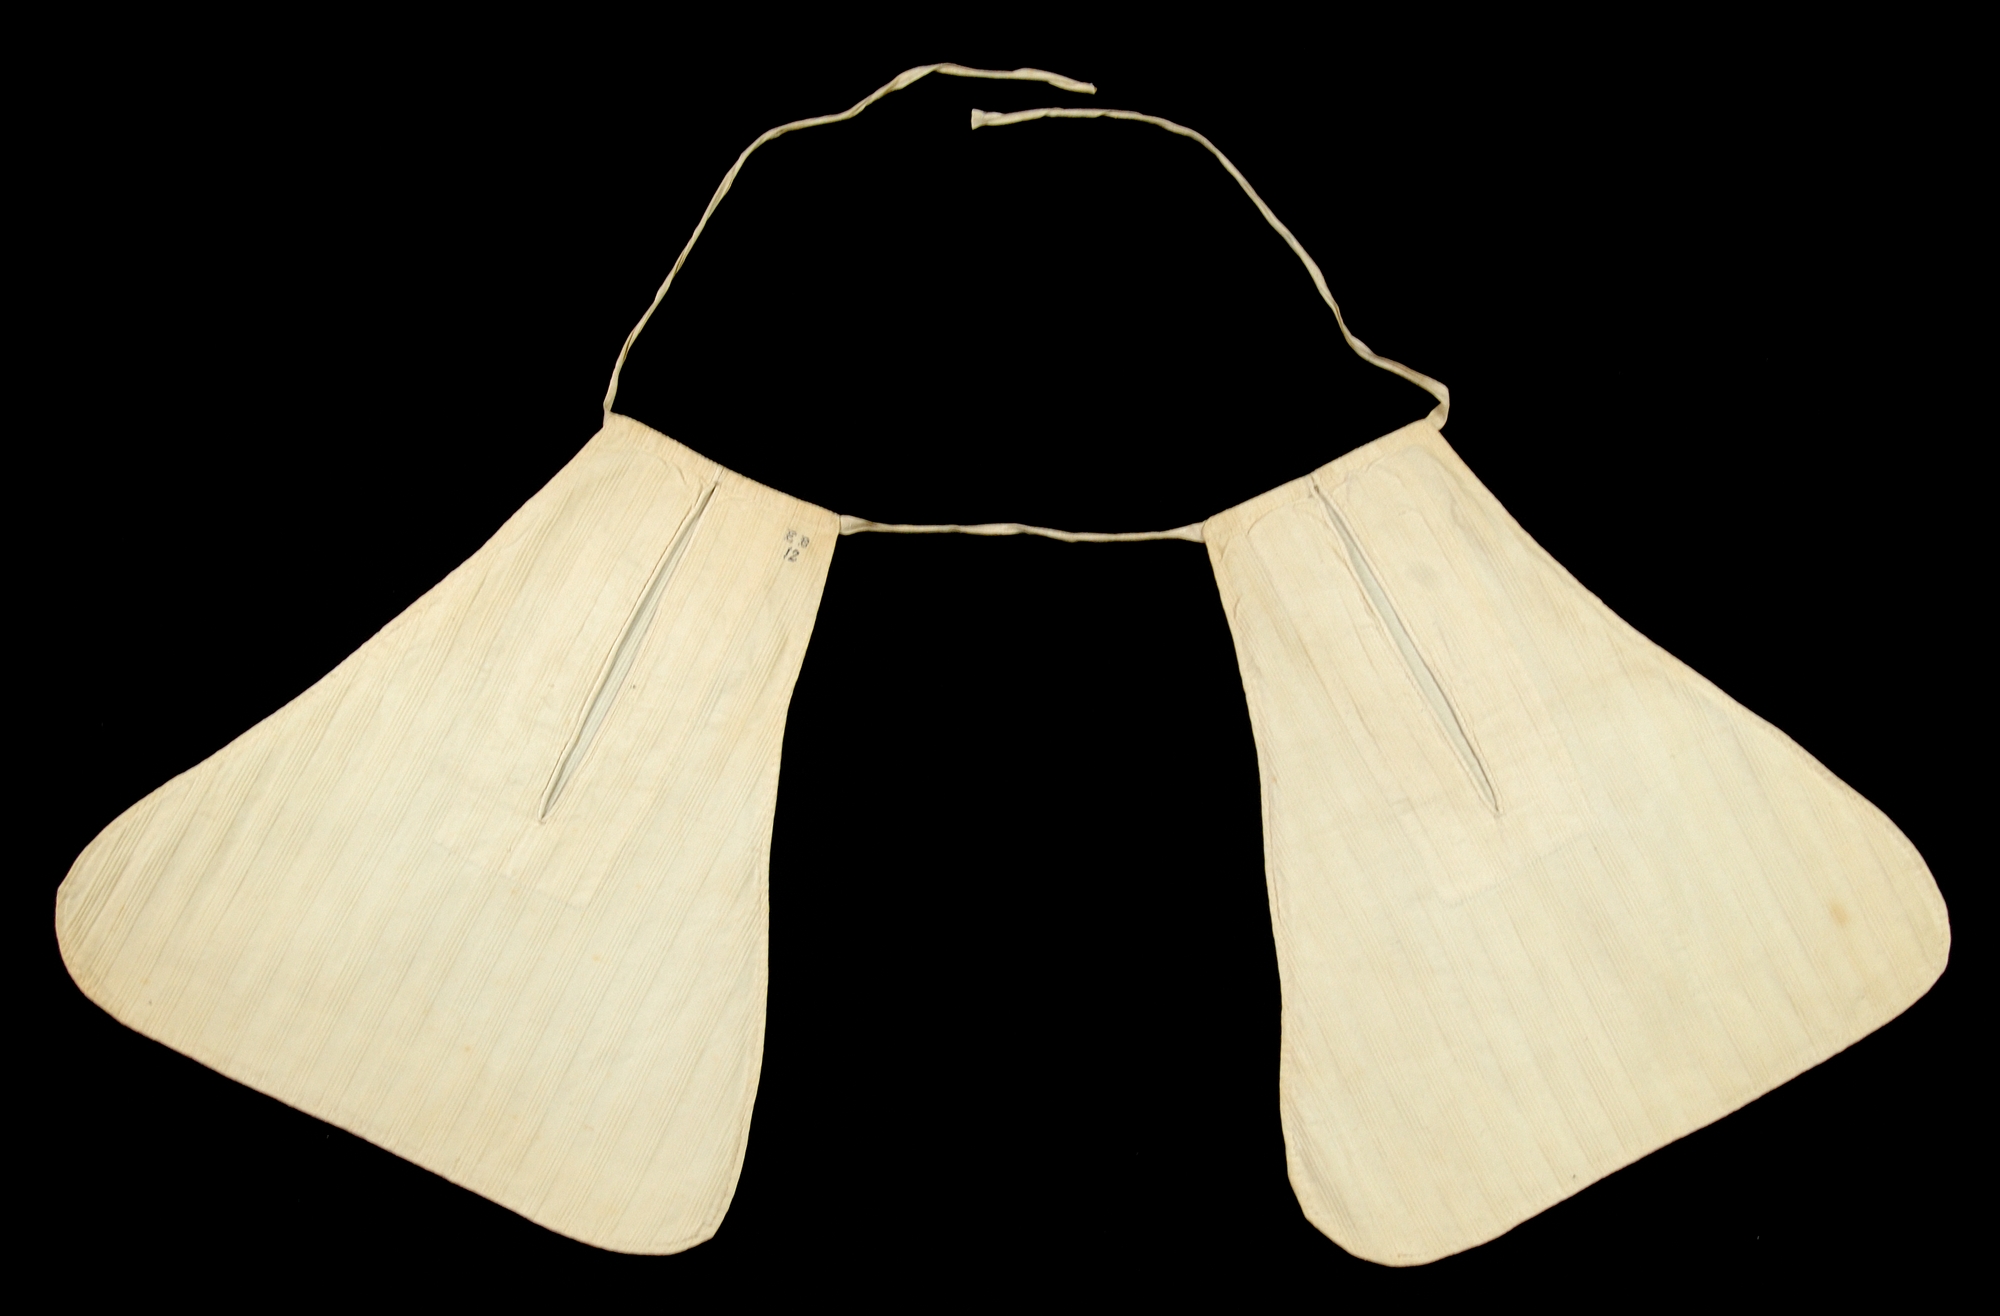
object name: pocket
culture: american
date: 1860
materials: cotton